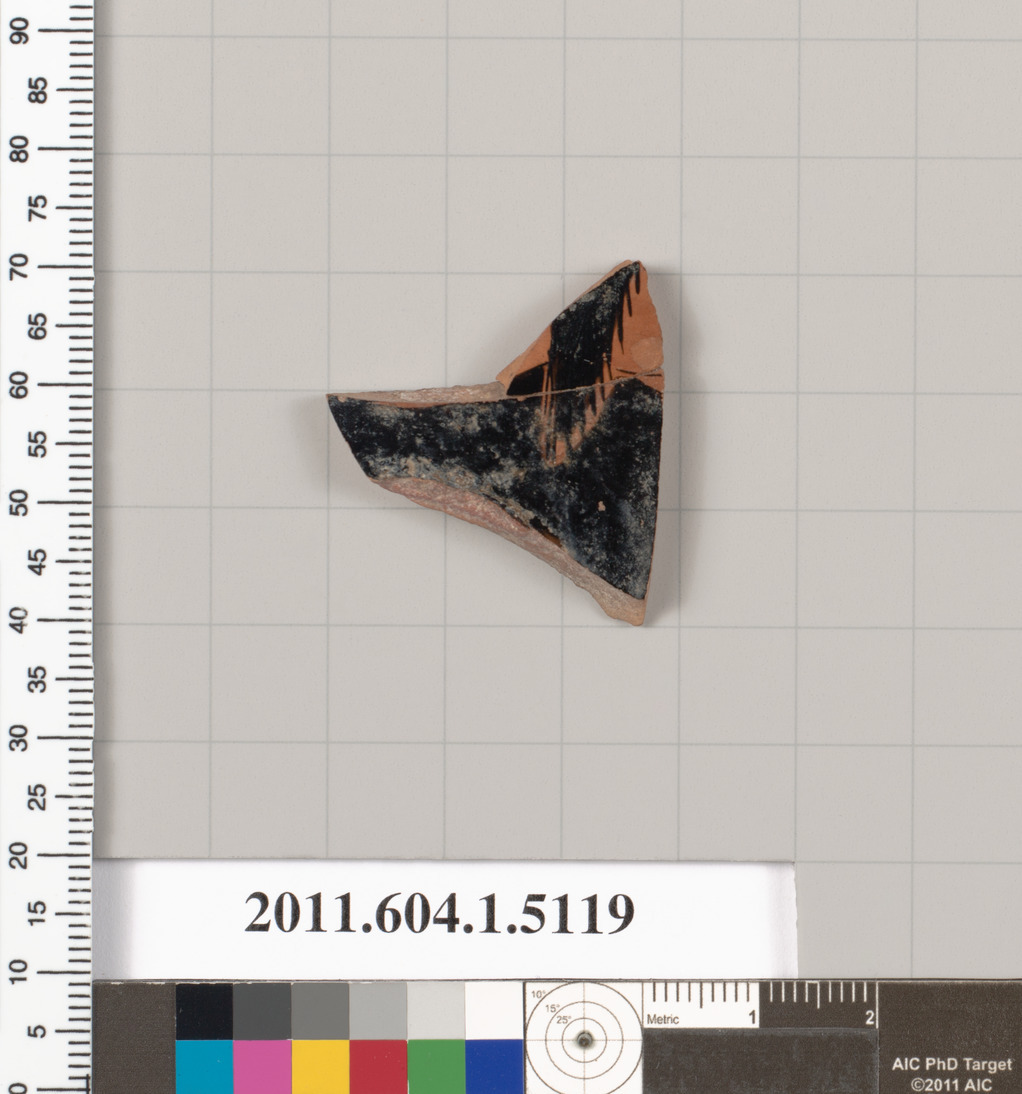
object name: kylix fragment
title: Terracotta fragment of a kylix (drinking cup)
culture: greek, attic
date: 520-490 BCE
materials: terracotta